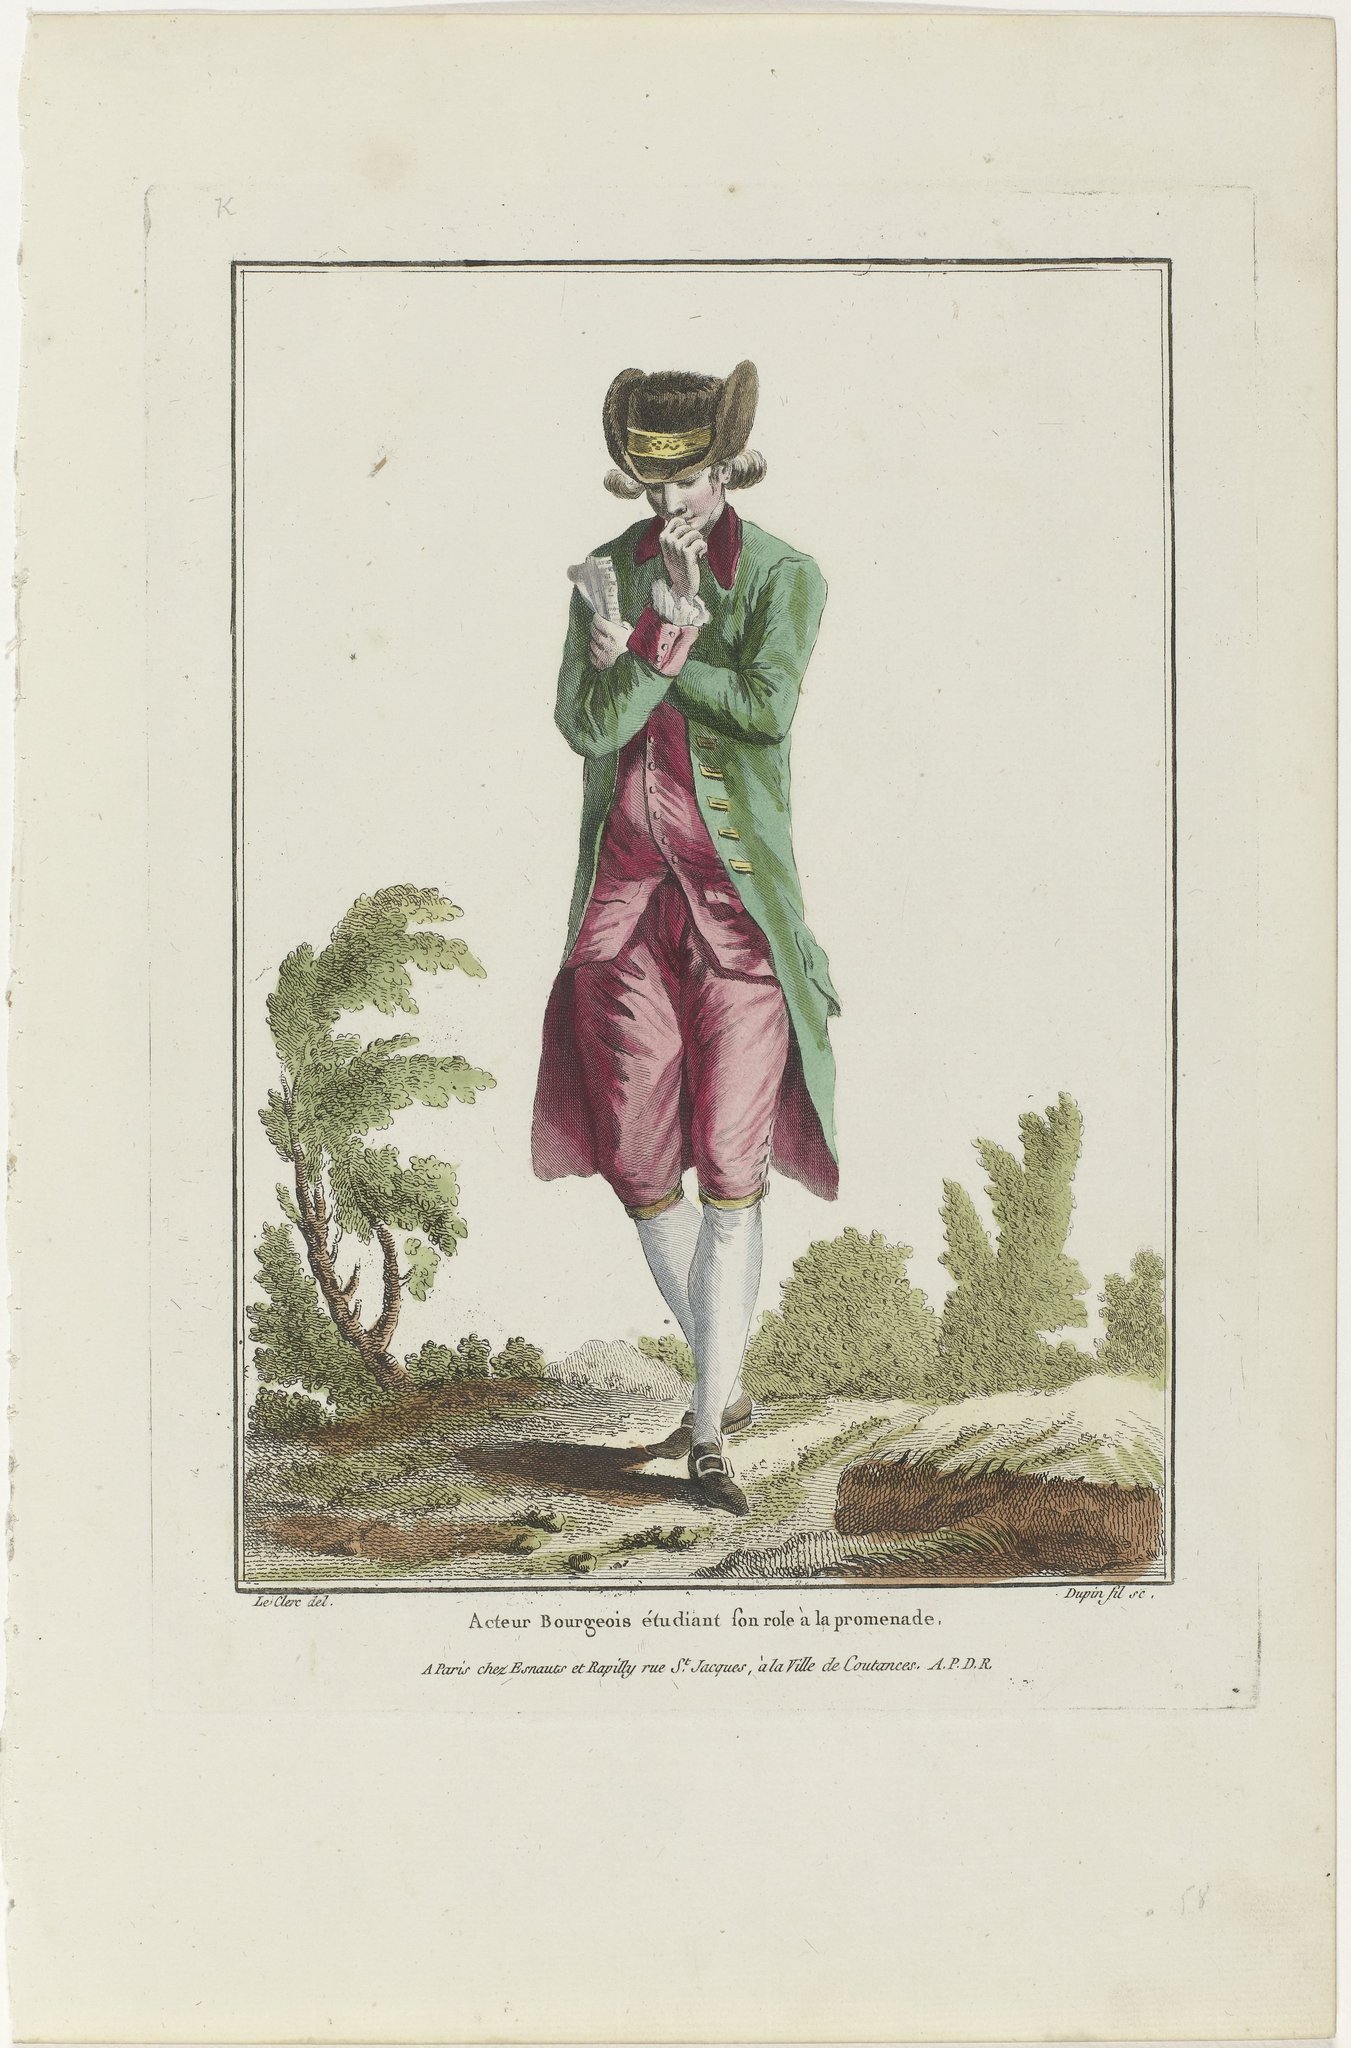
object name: fashion print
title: Gallerie des Modes et Costumes Français, 1778, K 58 : Acteur Bourgeois étudiant (...)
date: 1778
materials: paper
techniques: engraving, hand coloring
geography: paris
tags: clothing for the upper part of the body (vest) (+ men's clothes), head-gear: hat (+ men's clothes), fashion plates, actor, actress (non-work situations), letter, envelope, trousers, breeches, etc. (breeches) (+ men's clothes), stockings, socks (+ men's clothes)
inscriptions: address: ‘A Paris chez Esnauts et Rapilly rue St. Jacques, à la Ville de Coutances. A.P.D.R.’, caption: ‘Acteur Bourgeois étudiant son role à la promenade.’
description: Jonge acteur, die, al wandelend, van een papier zijn rol instudeert. Hij draagt een frak over hemd en vest, kniebroek en schoenen met vierkante gespen. Hoed met twee opstaande randen. Prent uit serie K. 10e Cahier de Costumes Français, 4e Suite d'Habillements à la mode, Gallerie des Modes et Costumes Français.